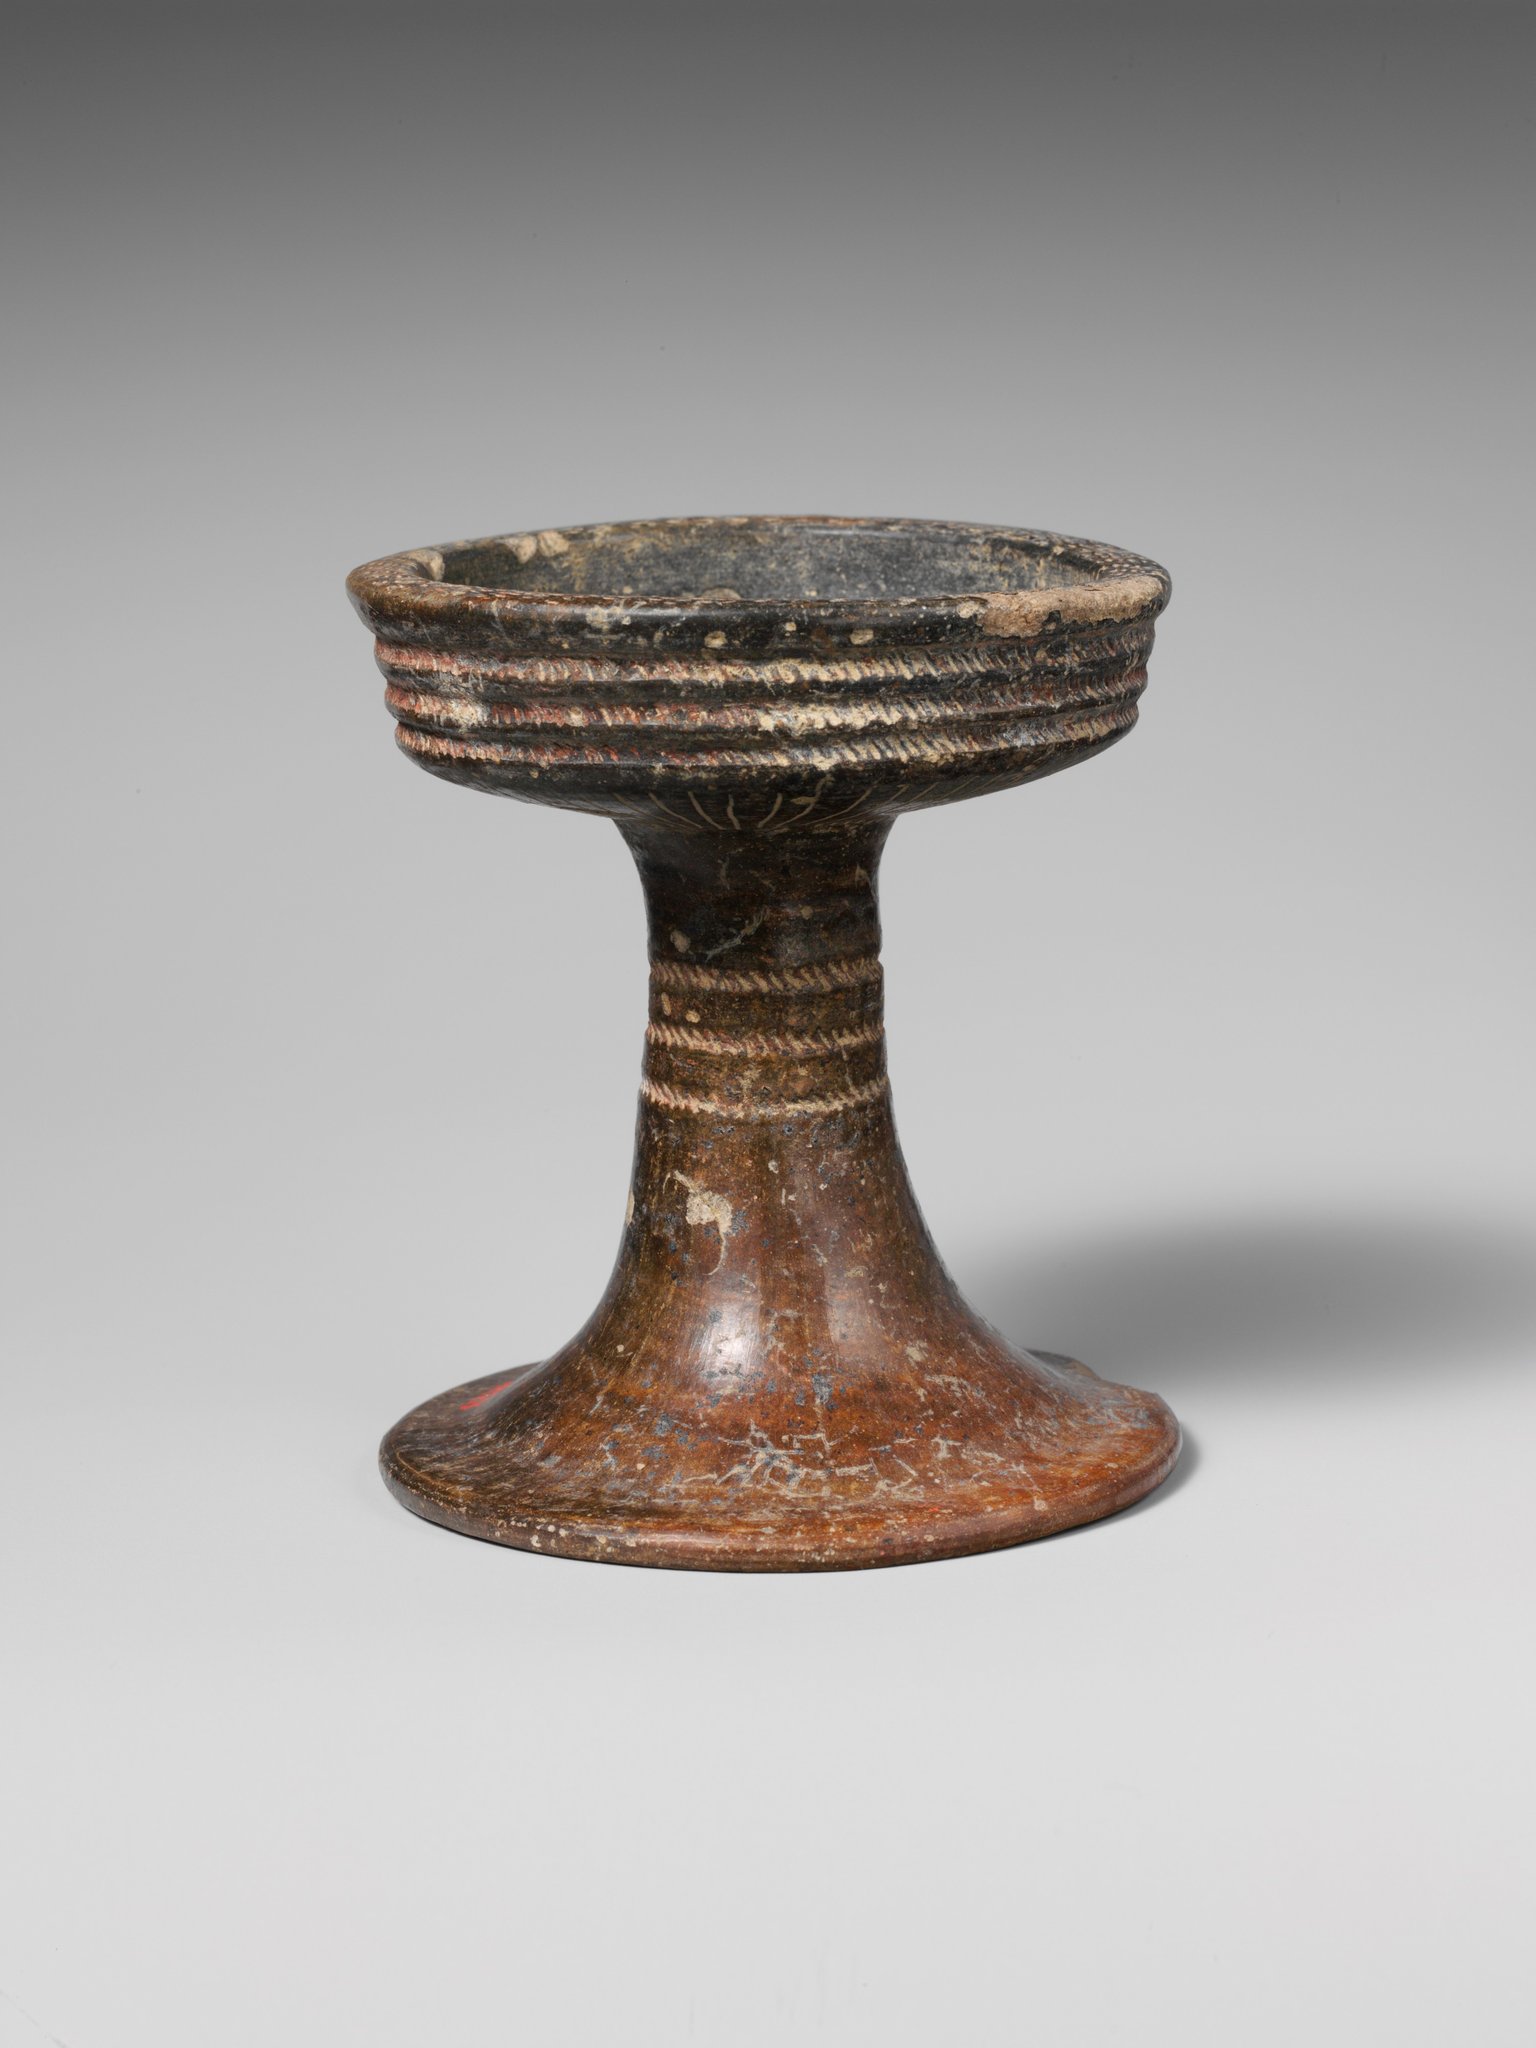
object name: dish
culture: italic, villanovan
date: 900-100 BCE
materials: terracotta